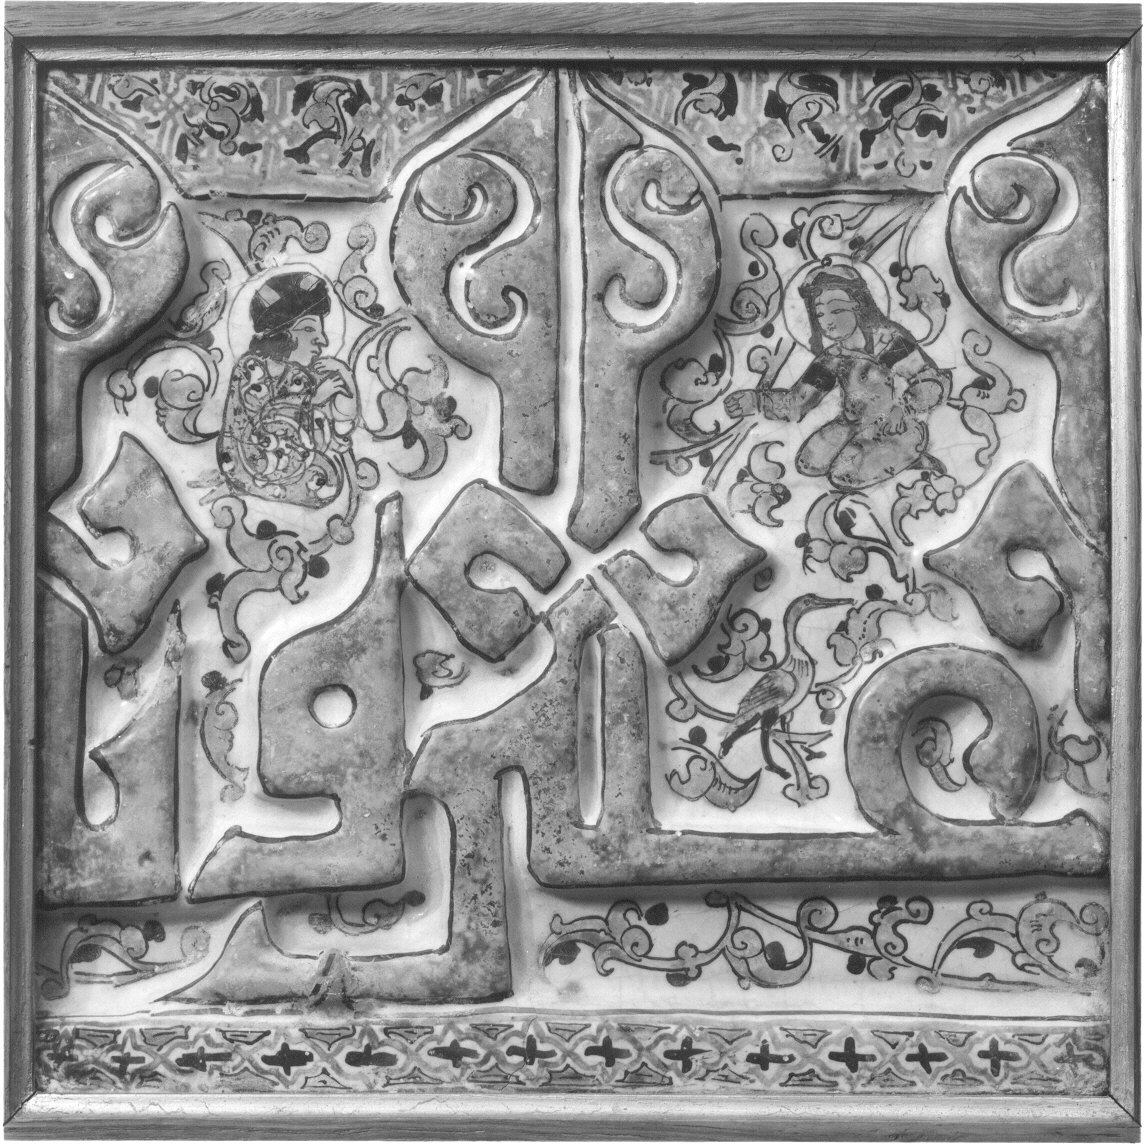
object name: tile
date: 1167-1300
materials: glaze, stonepaste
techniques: gilding, overglaze, painting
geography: iran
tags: birds,men,women